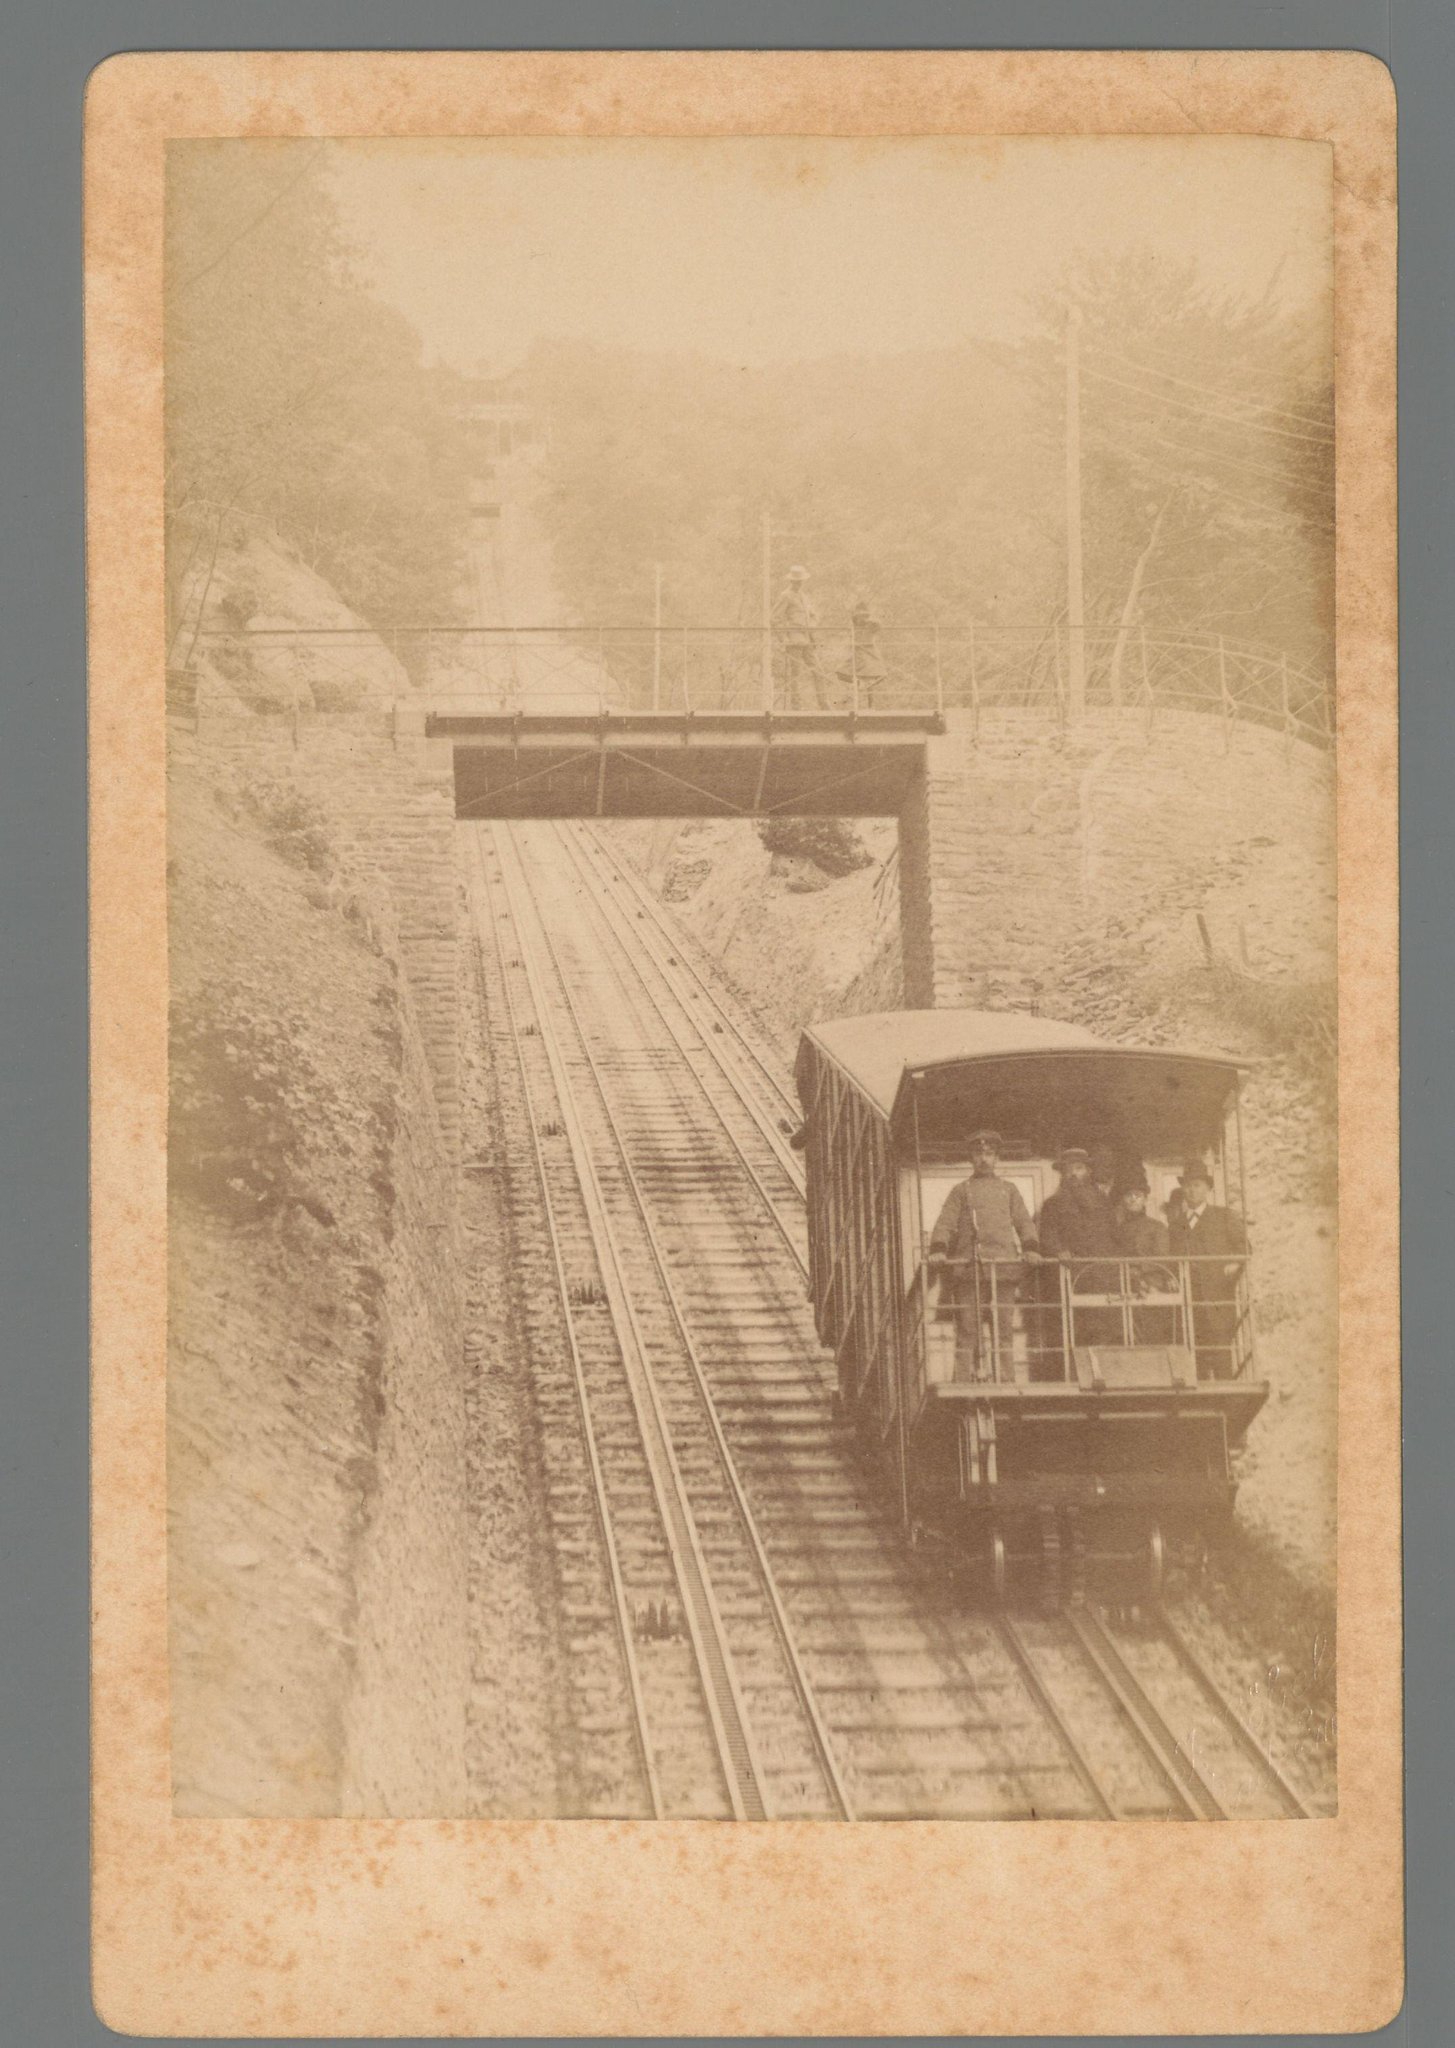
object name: cabinet photograph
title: Gezicht op de Mahlberg-spoorweg te Eems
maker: Anonymous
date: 1866-1920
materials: cardboard, photographic support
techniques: photography, writing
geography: bad ems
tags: railway, train, mountains